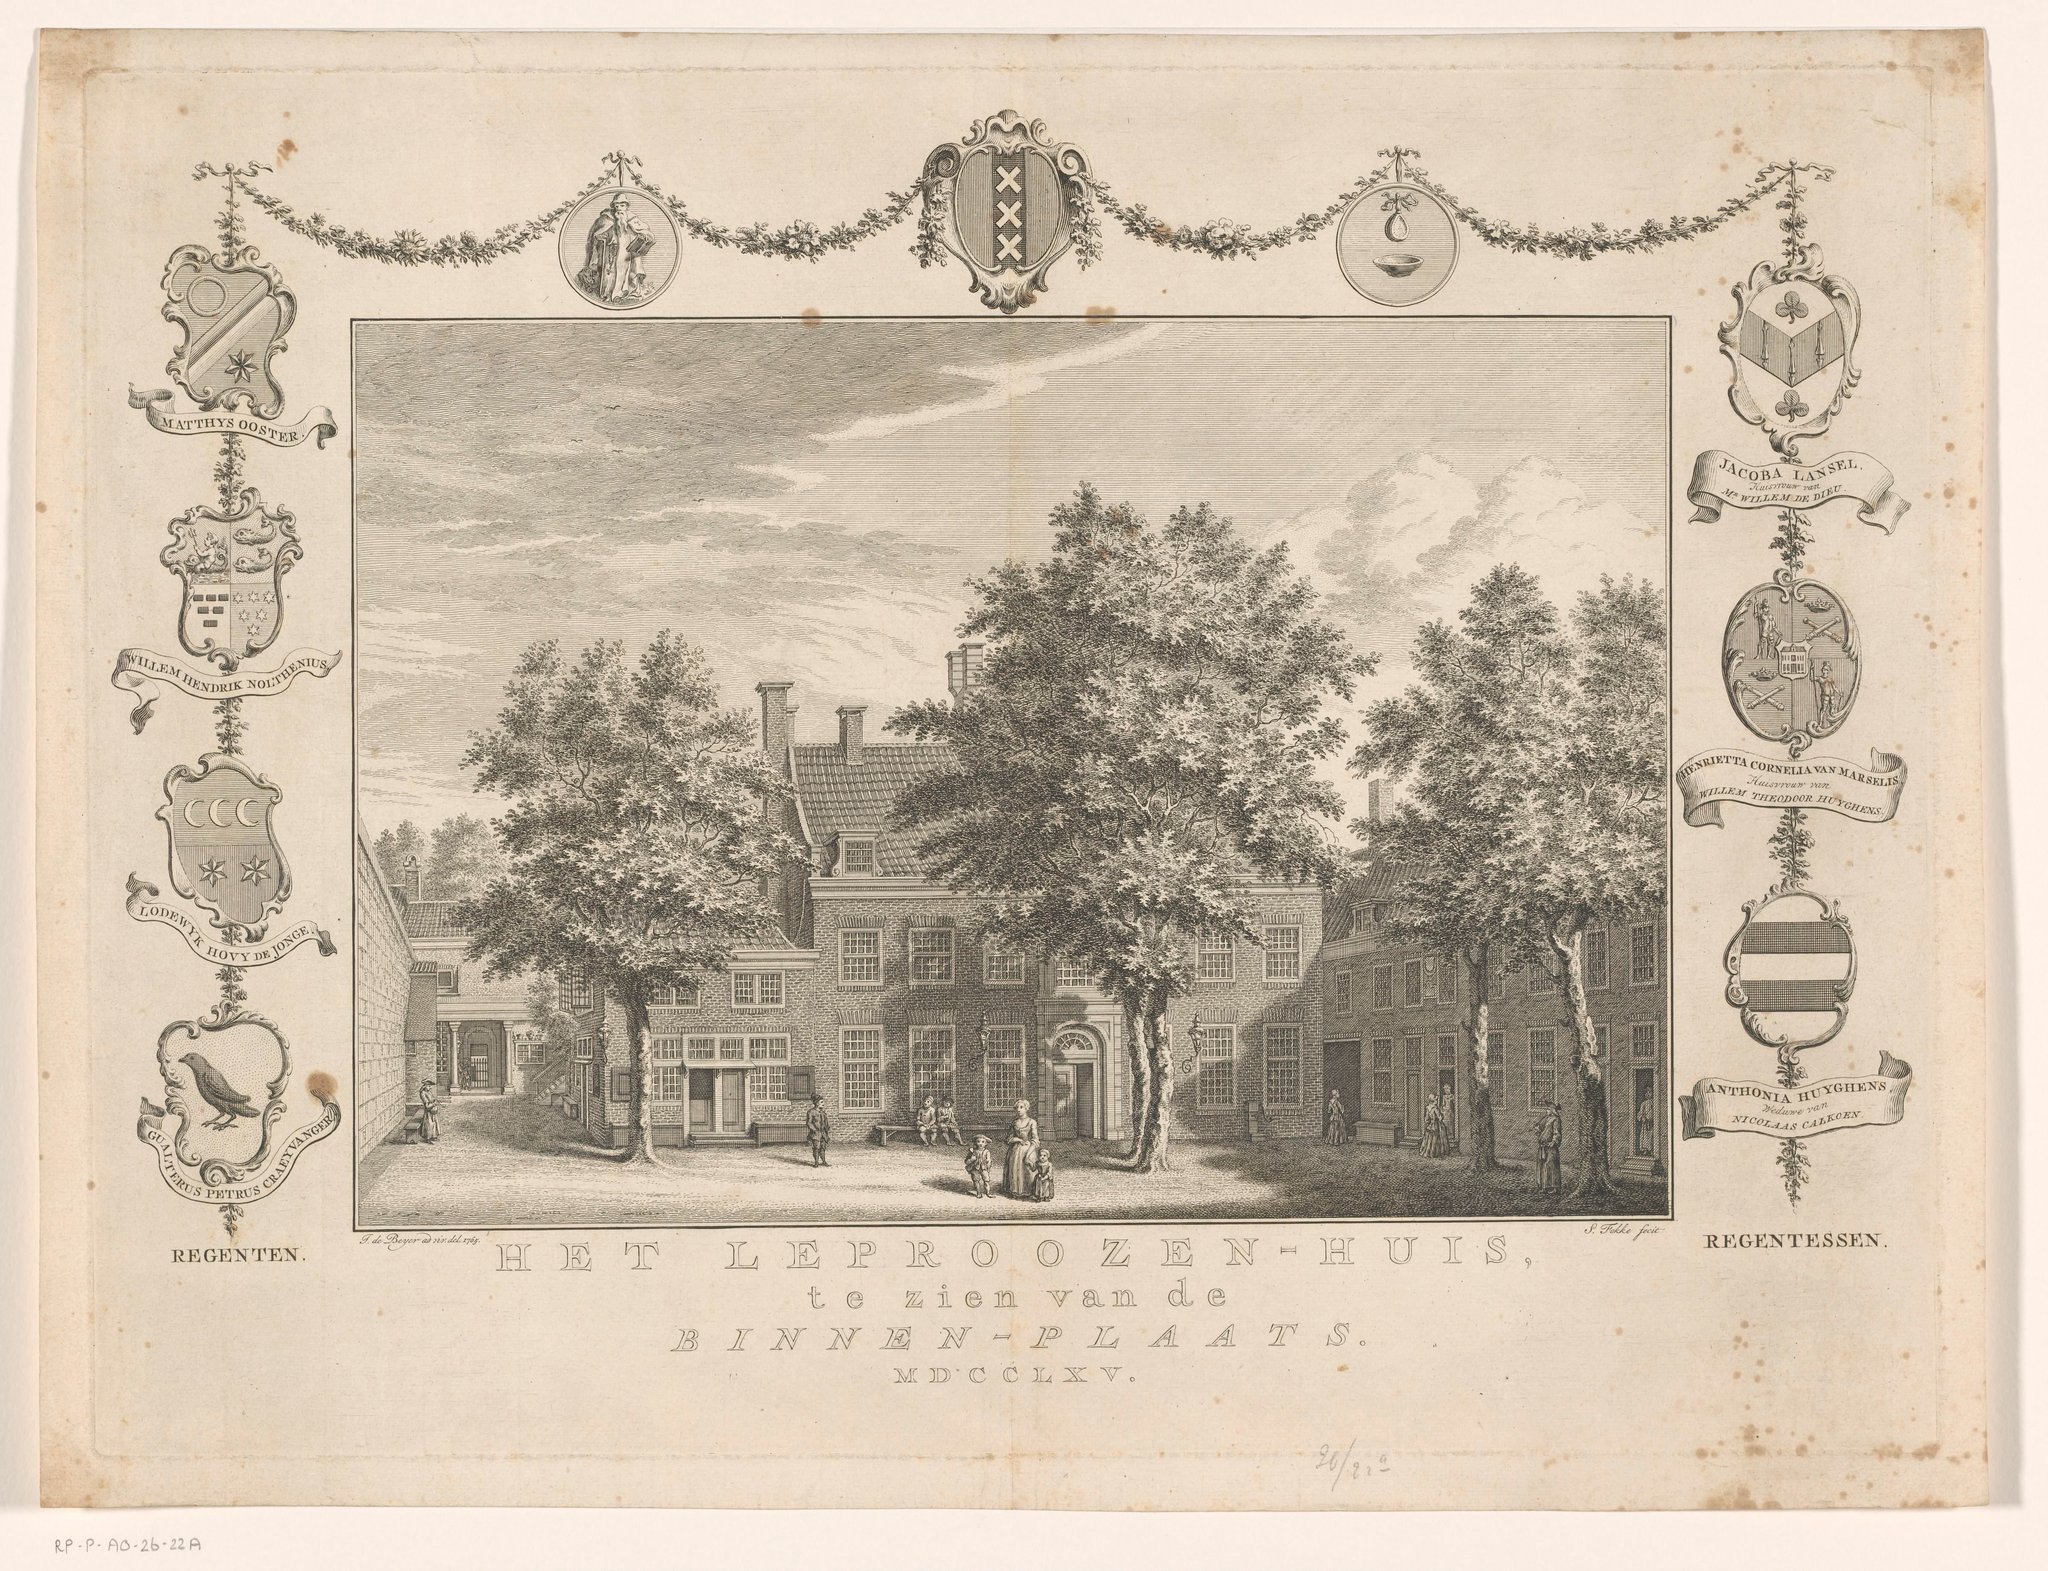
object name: print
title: Het Leproozen-Huis, te zien van de binnen-plaats. MDCCLXV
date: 1765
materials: paper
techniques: engraving, etching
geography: amsterdam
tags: coat of arms (as symbol of the state, etc.) (+ city; municipal), leprosarium, public welfare, hospital, courtyard, lunatic asylum, mental home, armorial bearing, heraldry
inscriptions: collector's mark: Lugt 2228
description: Gezicht op de binnenplaats van het Leprozenhuis te Amsterdam, gelegen aan de Lazarussteeg tegenover de Portugese Synagoge, 1765. Rond de voorstelling een guirlande, met aan de zijkanten de wapens van de regenten en regentessen uit het jaar 1765 en bovenaan een medaillon met Sint-Antonius, het wapen van Amsterdam en een medaillon met een leprozenklepper en een bedelnap.